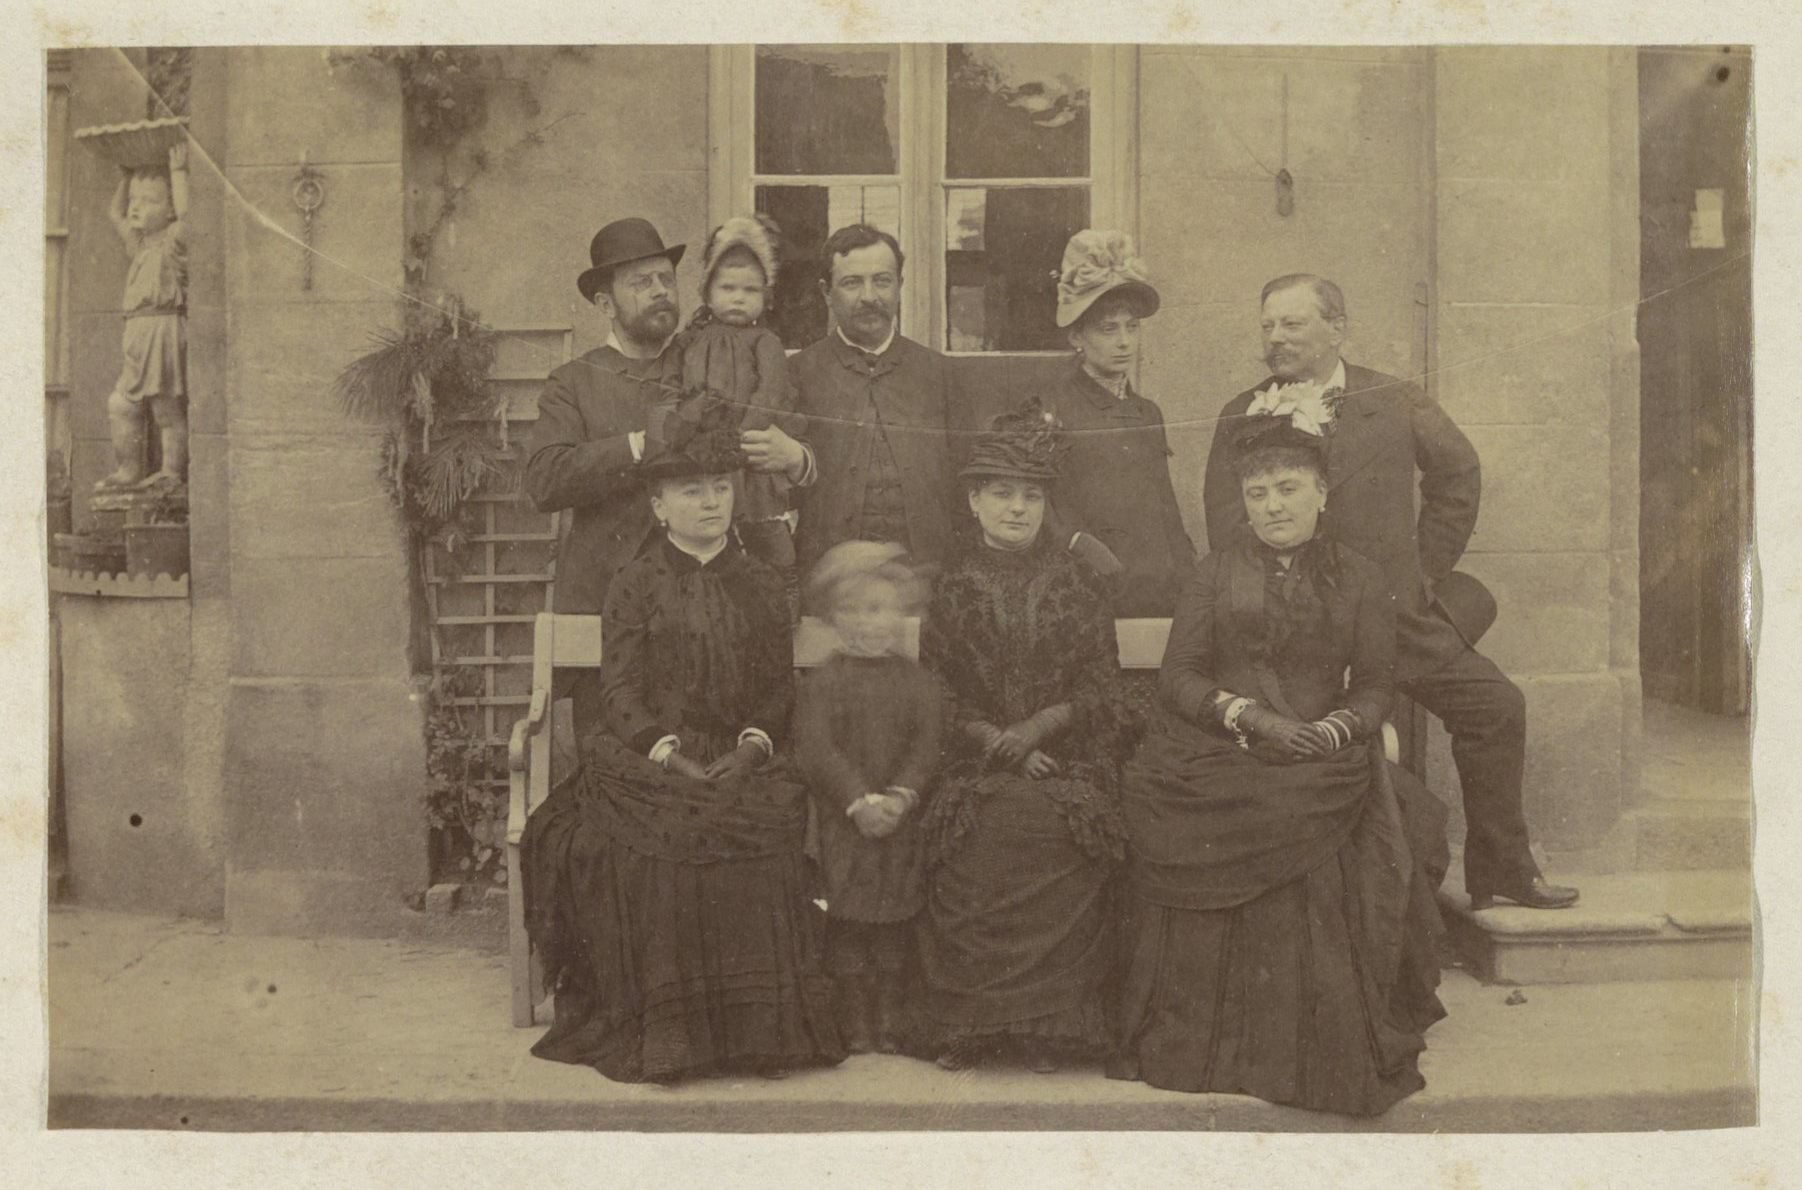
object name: photograph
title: Groepsportret van een Franse familie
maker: Anonymous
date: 1806-1885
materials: photographic support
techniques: albumen print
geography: france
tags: family group, especially parents with their child(ren)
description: Onderdeel van Album van een Franse amateurfotograaf met opnames van familie, militairen, industrie, landschappen en bezienswaardigheden in Frankrijk.